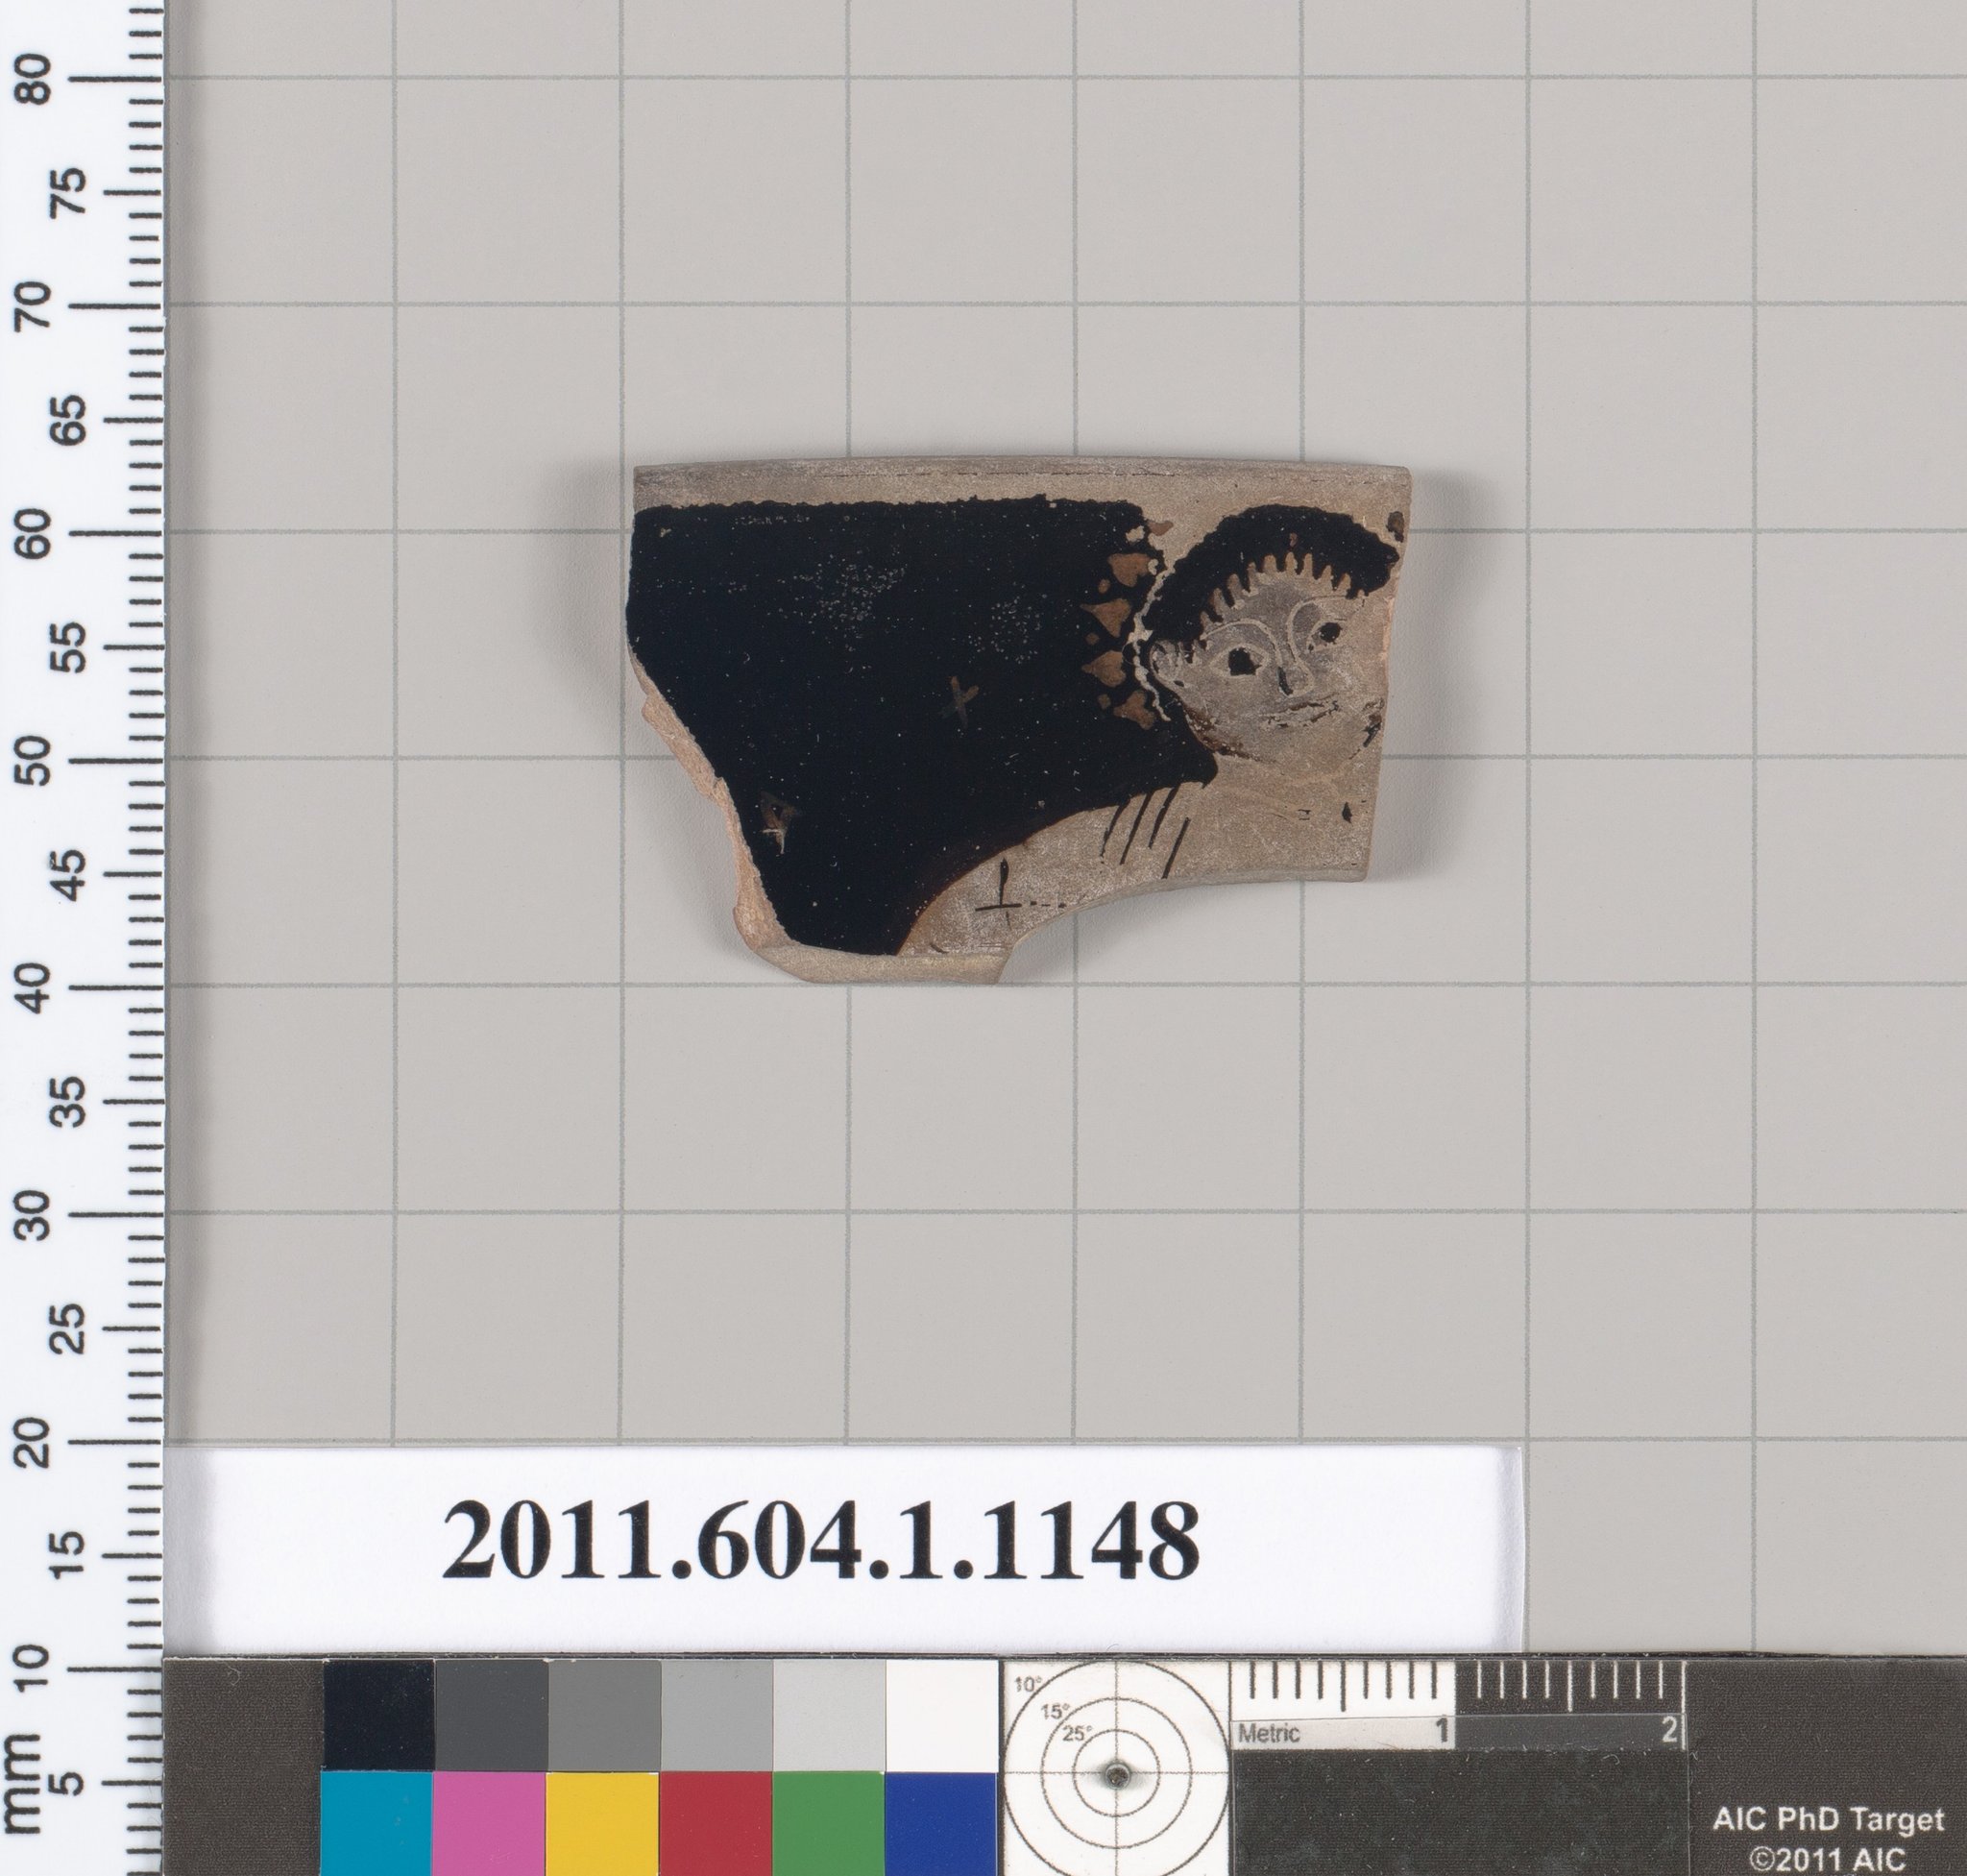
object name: kylix fragment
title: Terracotta rim fragment of a kylix (drinking cup)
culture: greek, attic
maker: ambrosios painter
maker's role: artist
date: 520-500 BCE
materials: terracotta